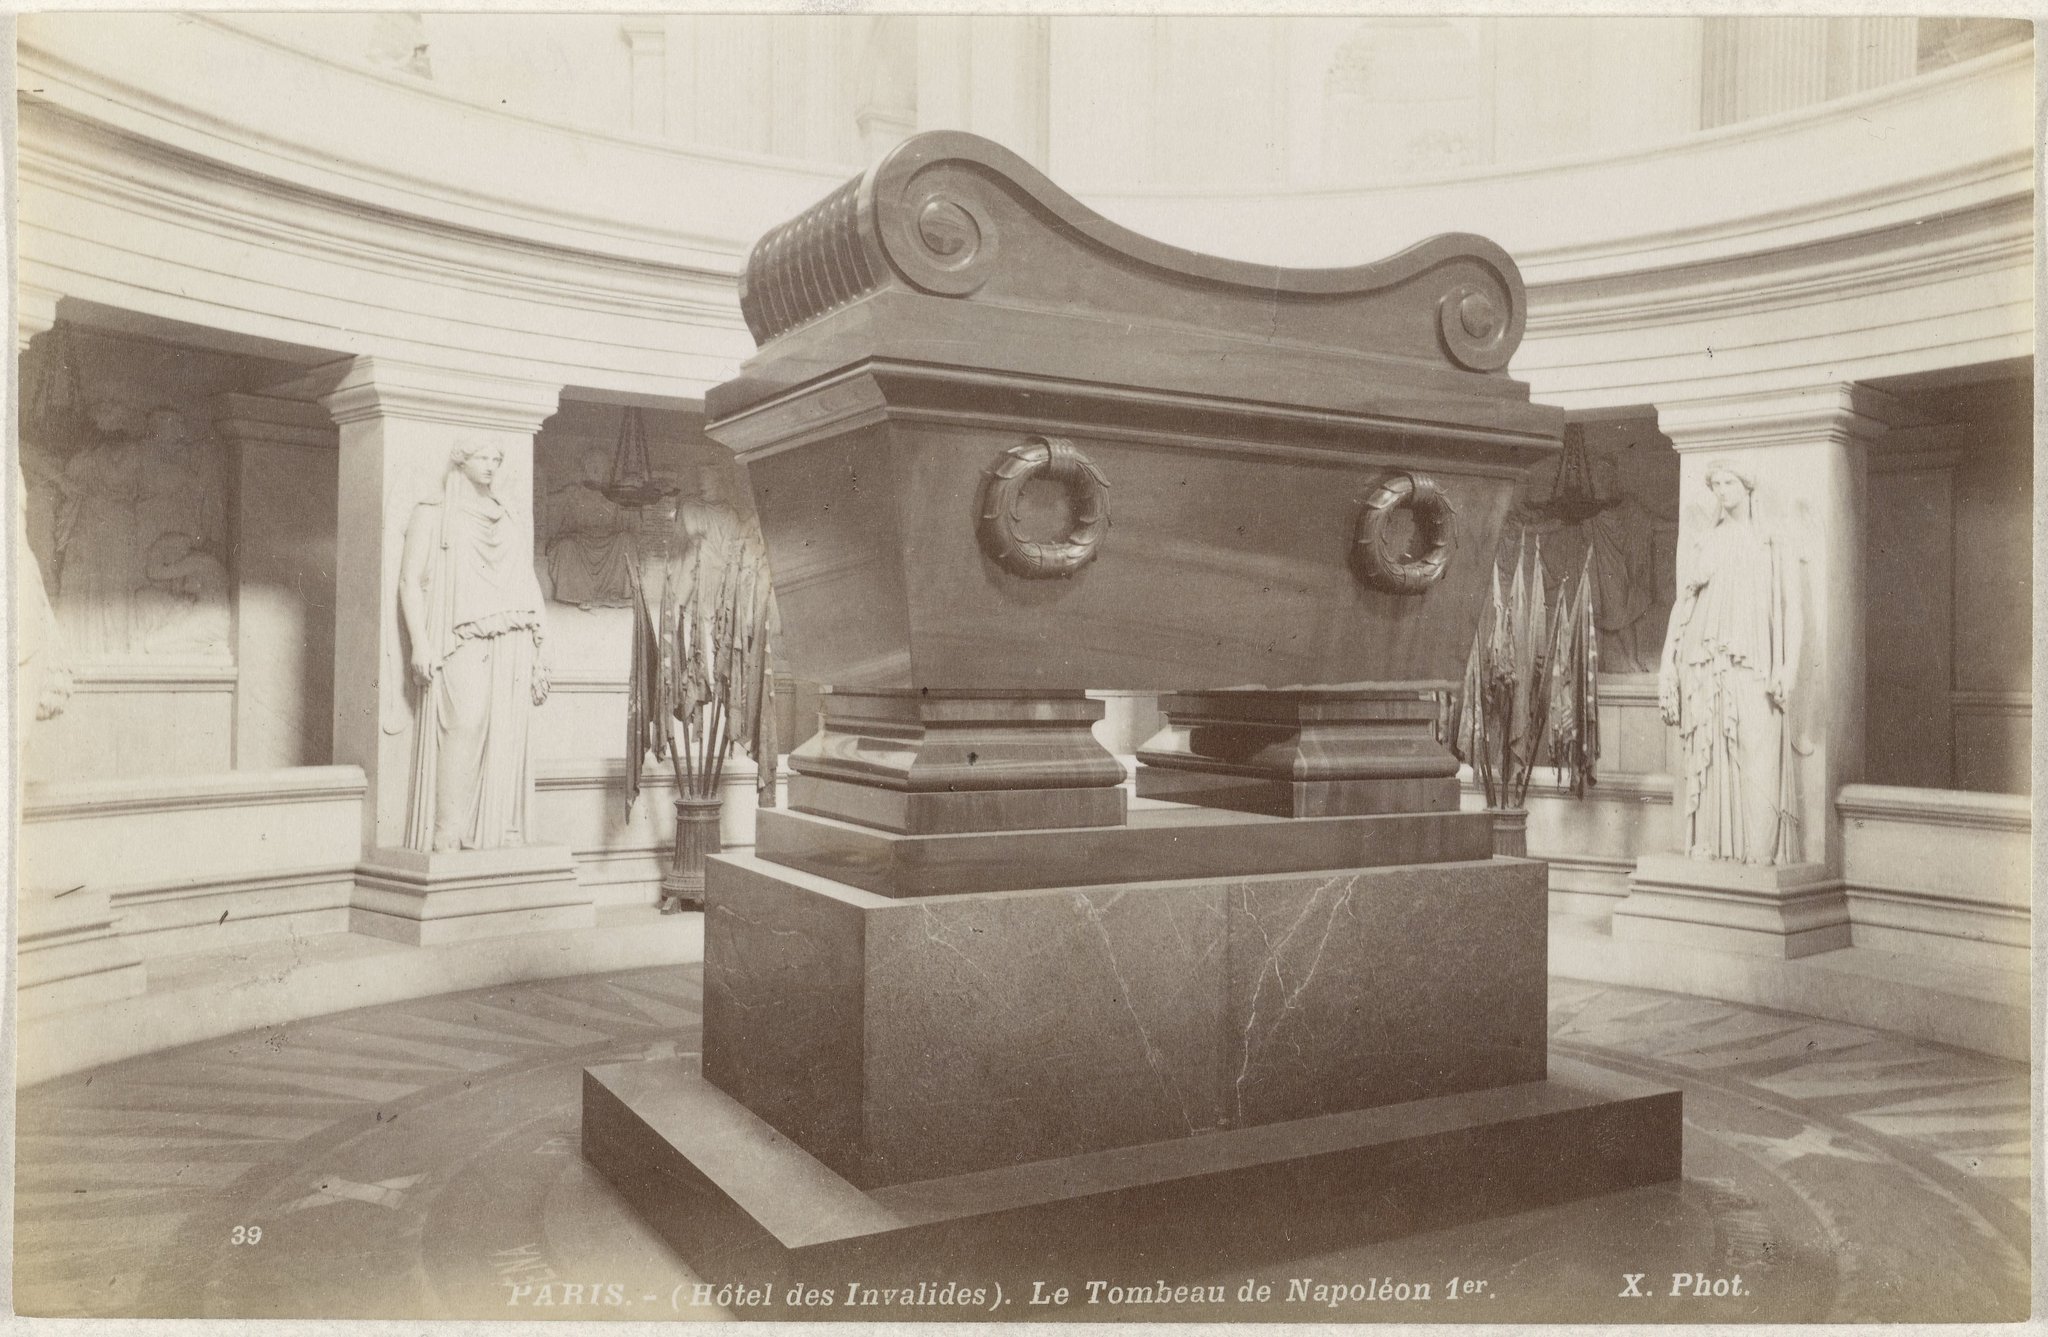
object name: photograph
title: Tombe van Napoleon Bonaparte in het Hôtel des Invalides, Parijs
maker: jules hautecoeur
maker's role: publisher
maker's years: 1849-1935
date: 1887-1900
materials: paper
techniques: albumen print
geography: paris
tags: napoleon i (emperor of the french), grave, tomb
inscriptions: number: ‘809’, inscription: ‘39/ Paris. - (Hôtel des Invalides). Le Tombeau de Napoléon 1er. X. Phot.’, stamp: ‘Jules Hautecoeur/ Paris/ 172 Rue de Rivoli’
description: Tussen 1887 en ca. 1900 werkten Neurdein frères onder andere onder de naam 'X phot.'.